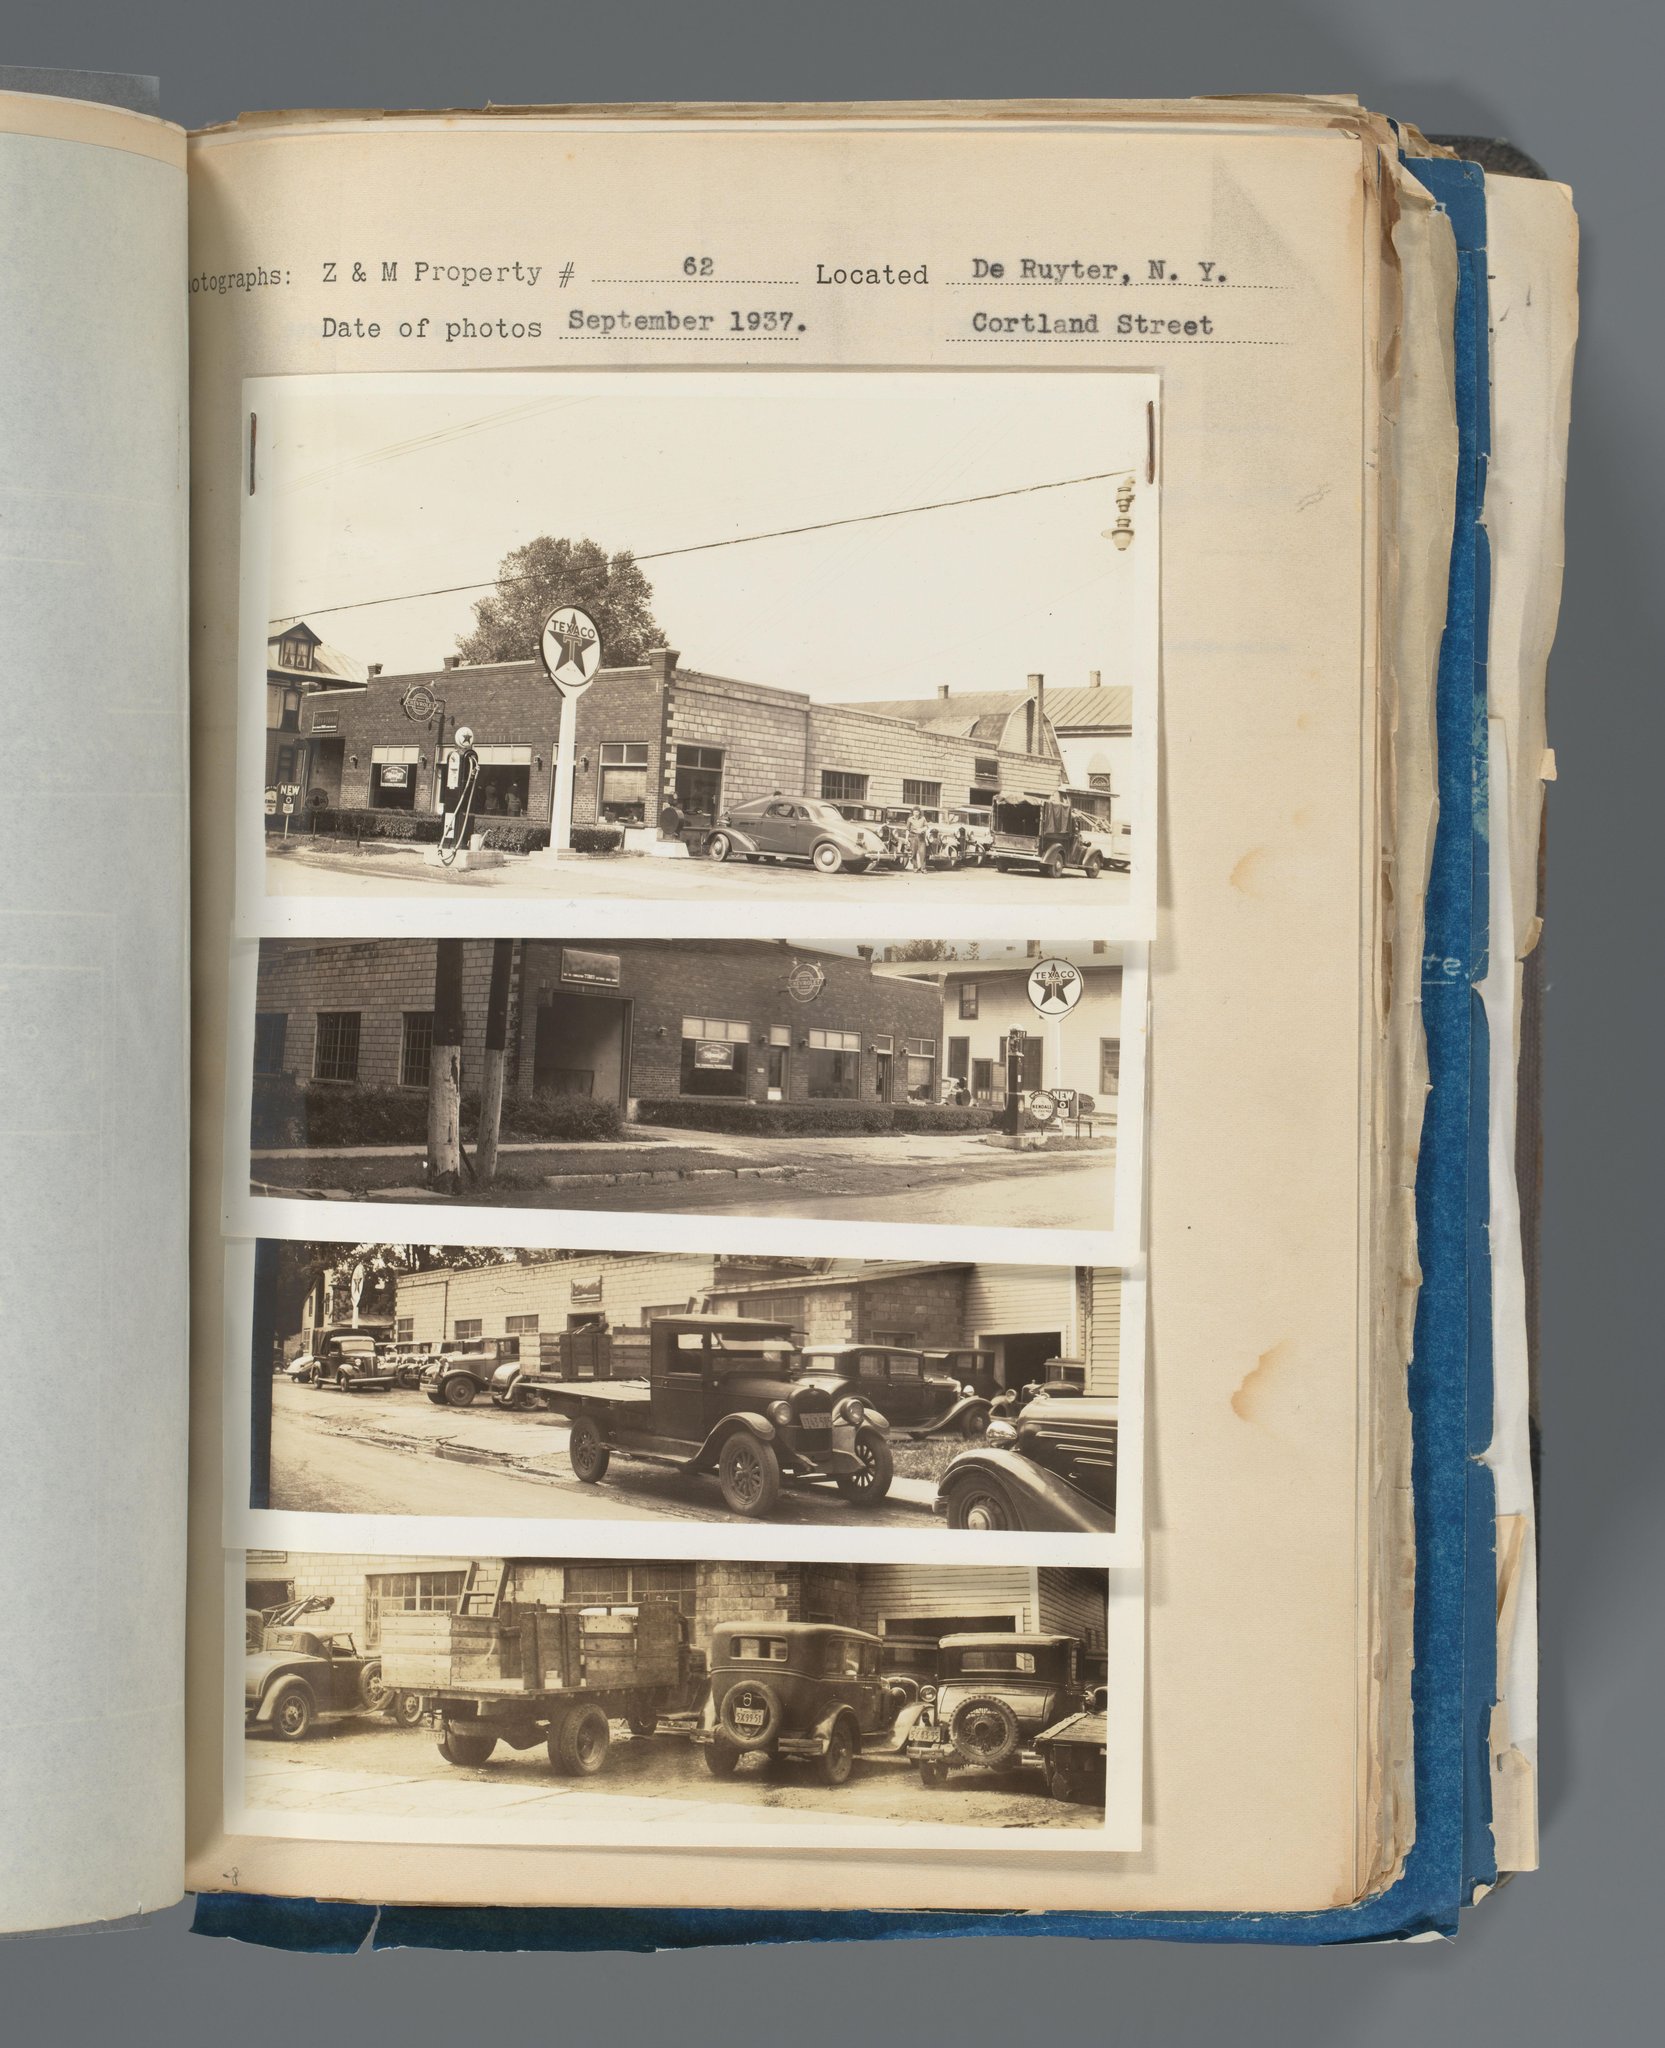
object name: album leaf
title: Vier gezichten op het benzinestation aan Cortland Street in DeRuyter, New York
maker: a.j. mcloughlin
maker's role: administrateur, fotograaf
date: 1909-1937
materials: paper, iron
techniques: gelatin silver print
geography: deruyter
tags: petrol pump, service station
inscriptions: number: ‘Z & M Property # 62’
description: Deze foto's zijn onderdeel van een album.